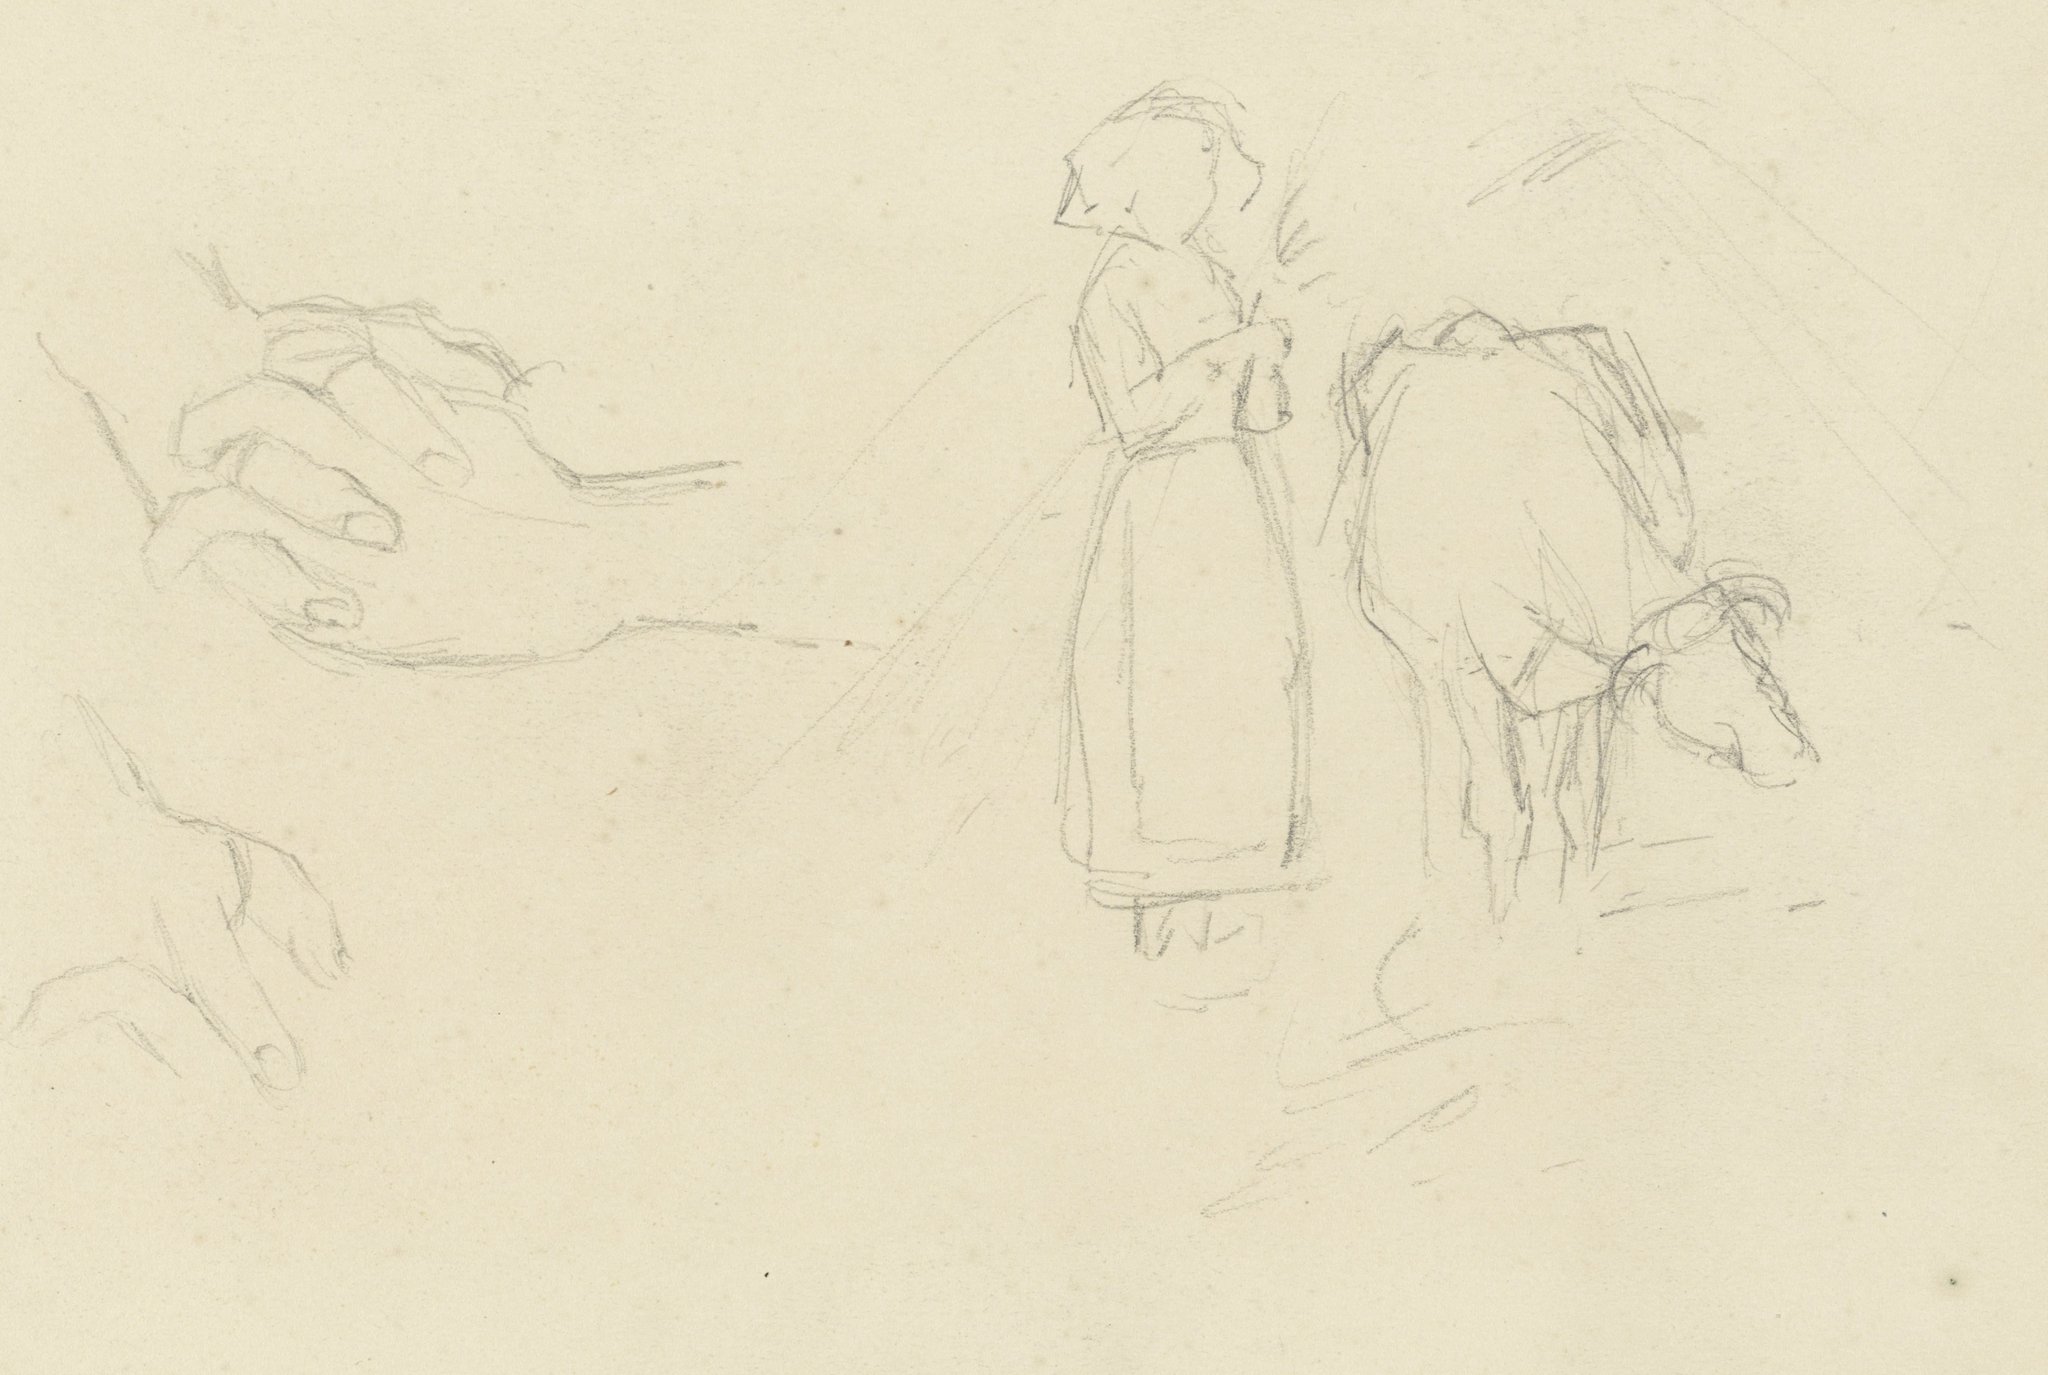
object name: drawing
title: Schetsen van handen, een meisje en een koe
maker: jozef israëls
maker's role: draughtsman, painter, print maker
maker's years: 1824-1911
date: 1834-1911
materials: paper, pencil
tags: head (human), cow